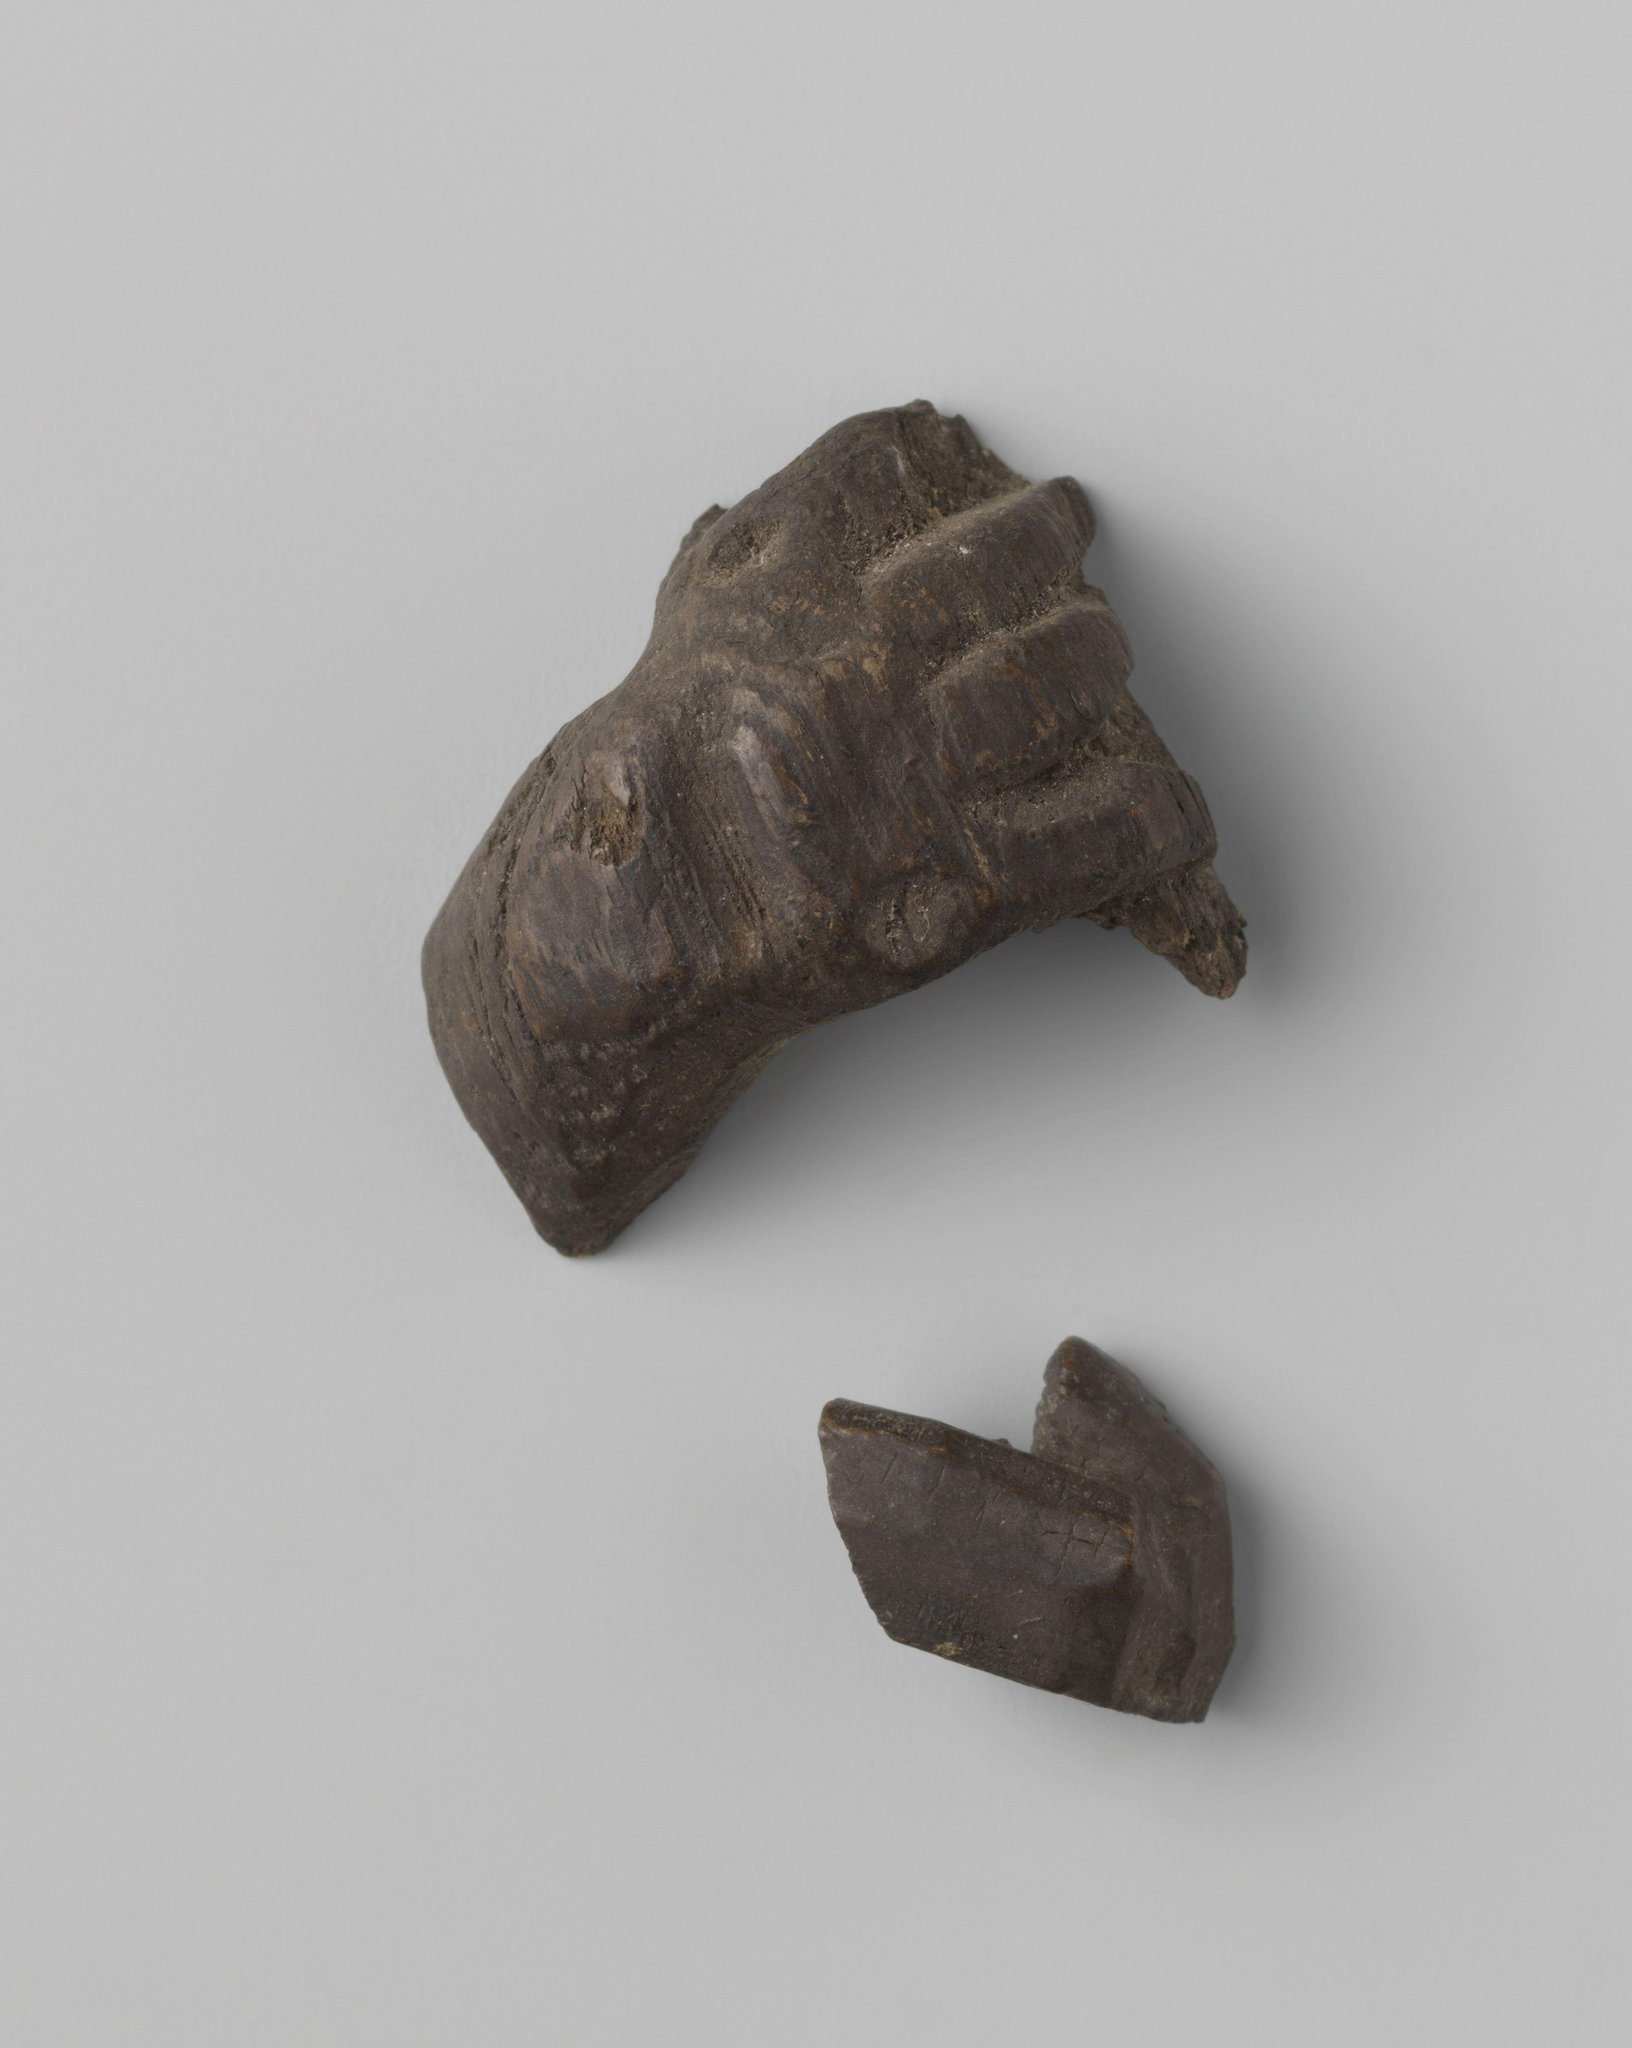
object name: sculpture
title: The Meeting of the Magi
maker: Anonymous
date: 1800-1900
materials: wood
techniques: cutting, polychromy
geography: netherlands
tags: the three wise men meet at the crossroads, den bosch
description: Hand en een klein ondefienieërbaar fragment.